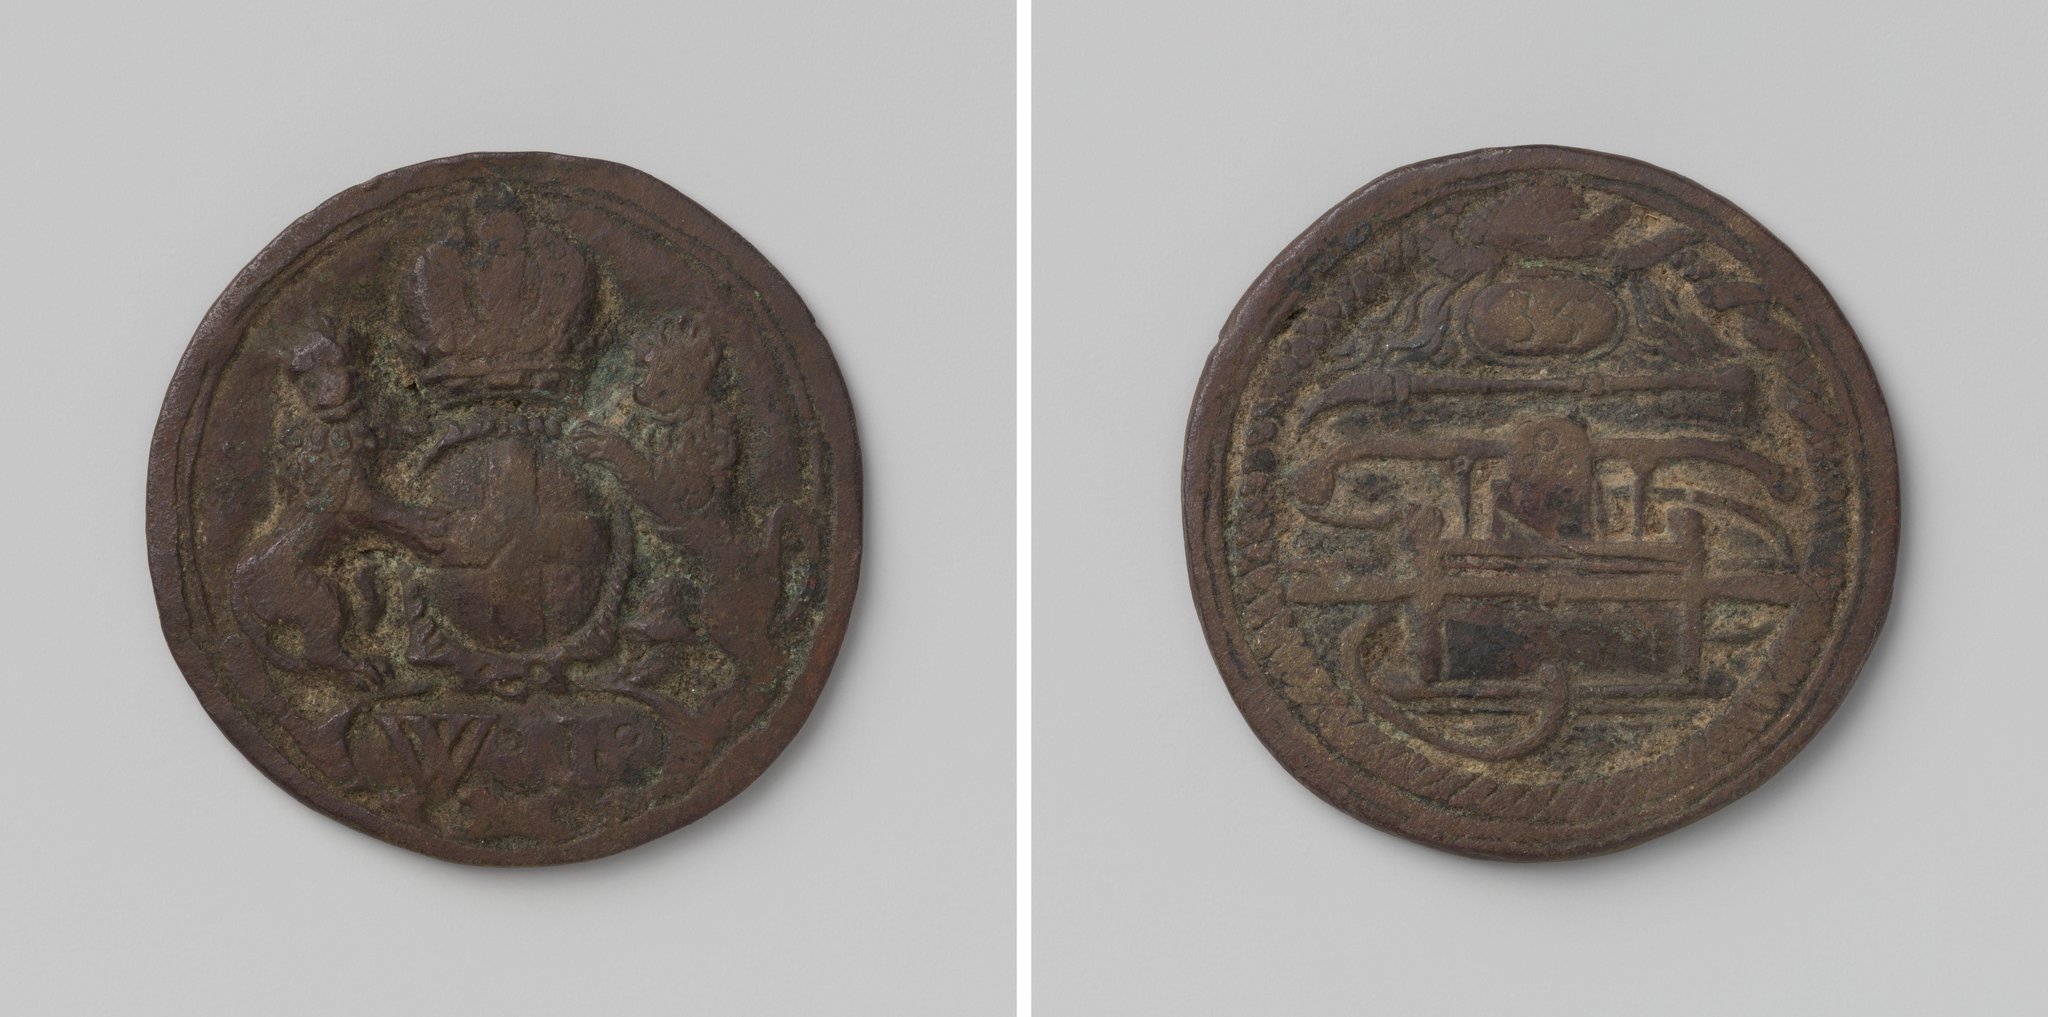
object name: medal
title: Zwolle, brandspuitpenning van wijk 1 met no. 35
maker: Anonymous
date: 1680-1800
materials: brass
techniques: casting, engraving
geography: zwolle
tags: zwolle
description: Messing penning. Voorzijde: gekroond wapenschild, geflankeerd door twee leeuwen boven cartouche met opschrift W.1. Keerzijde: brandspuit onder cartouche met cijfer 35 binnen slangerond